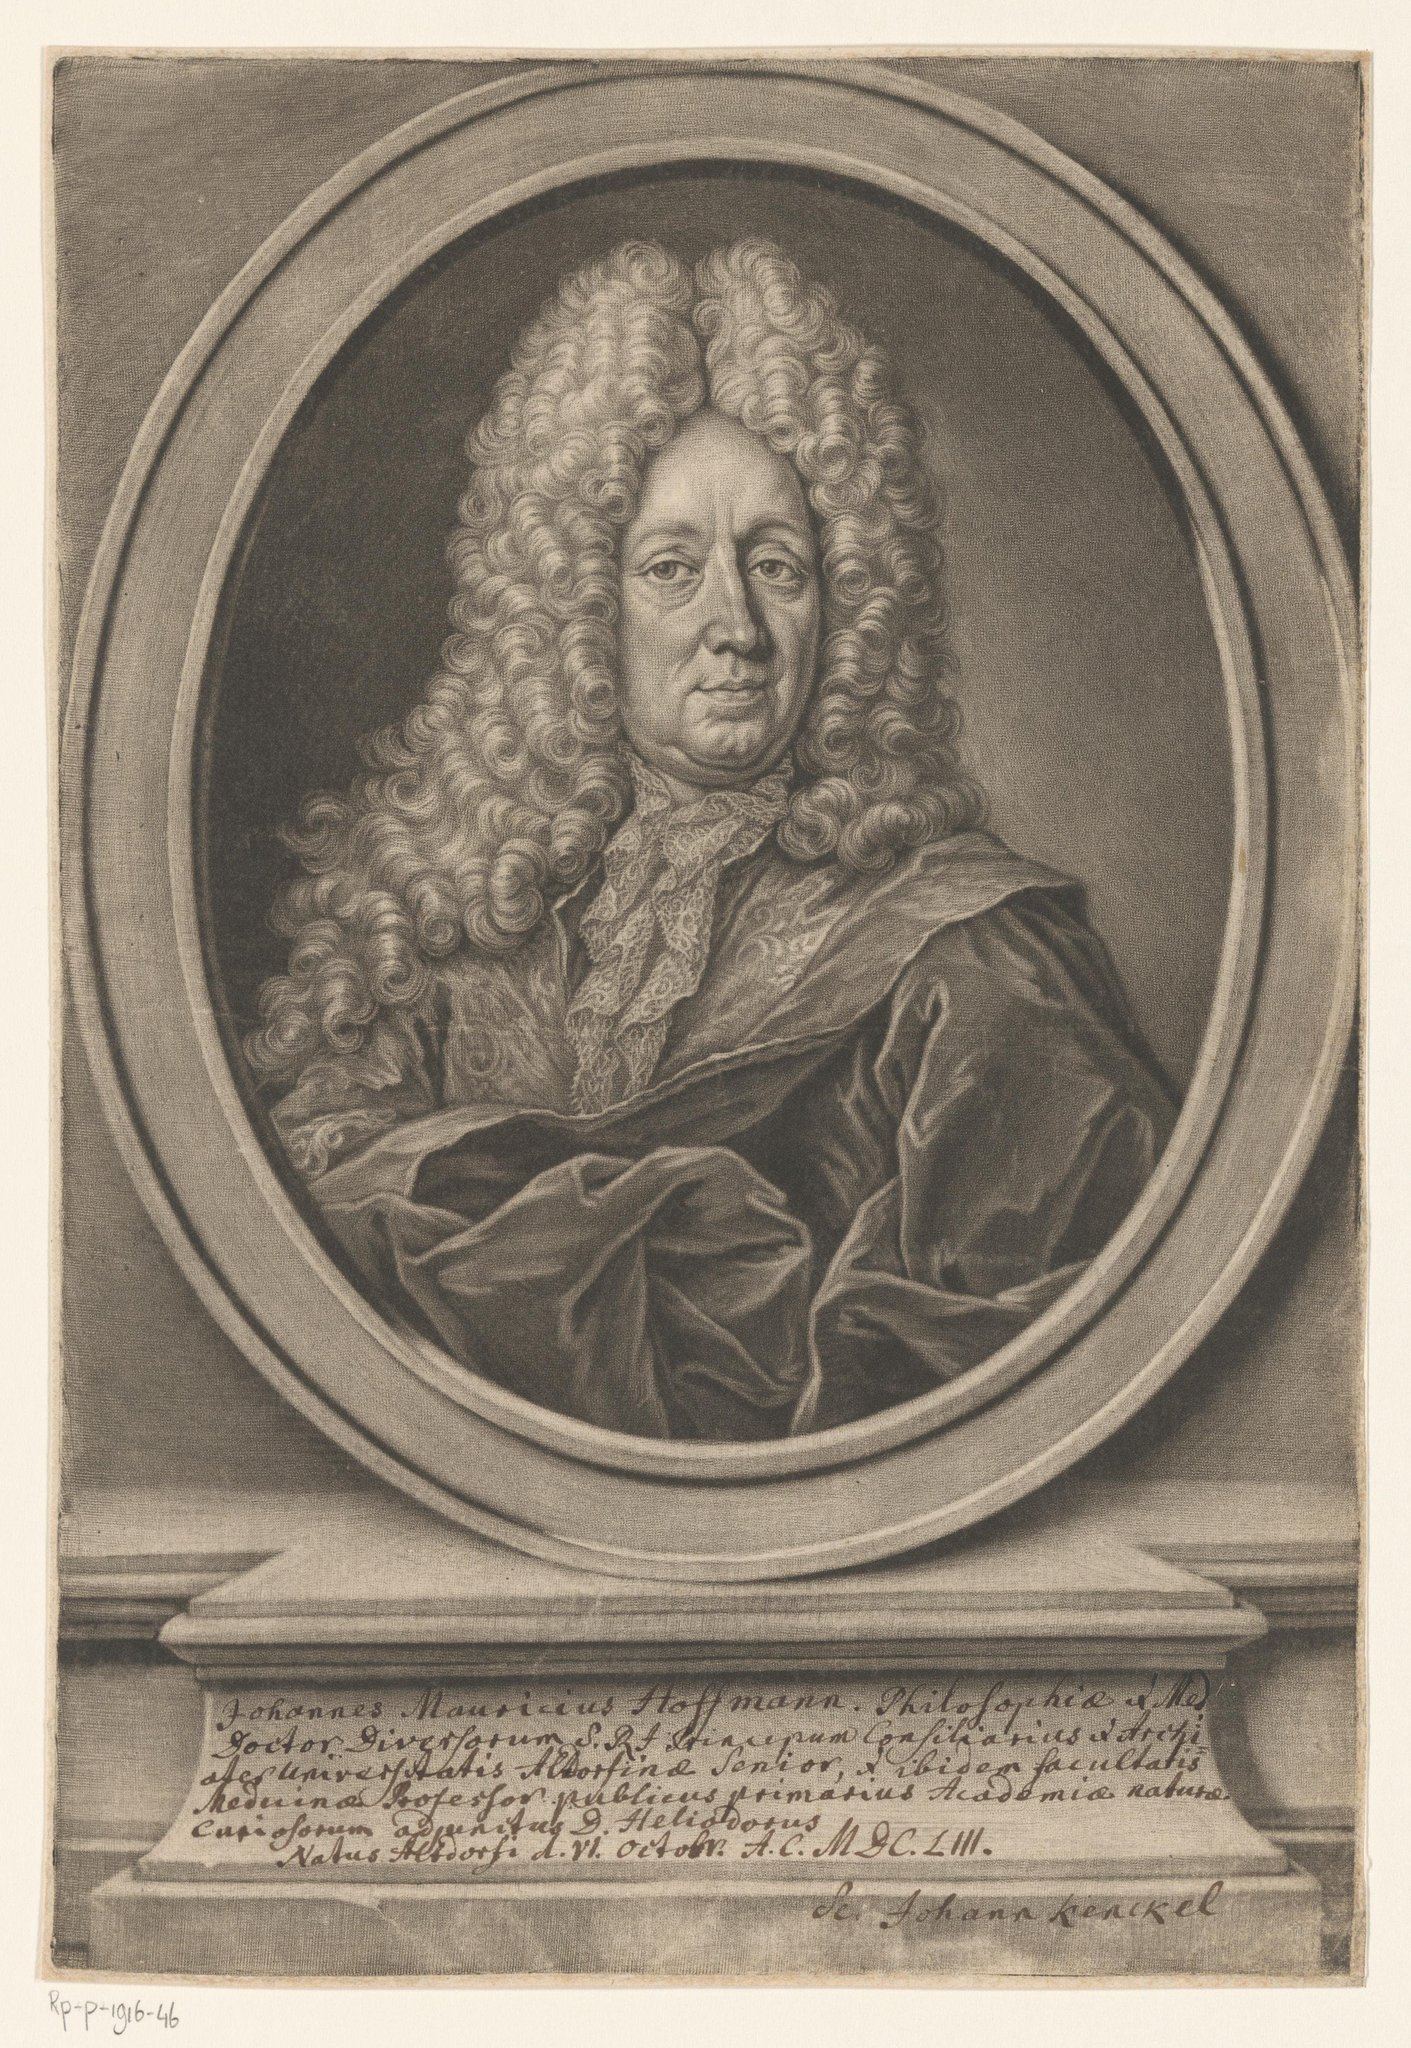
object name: print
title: Portret van Johann Moritz Hoffmann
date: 1711-1713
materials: ink, paper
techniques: pen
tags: historical persons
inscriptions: inscription, collector's mark: Lugt 2228